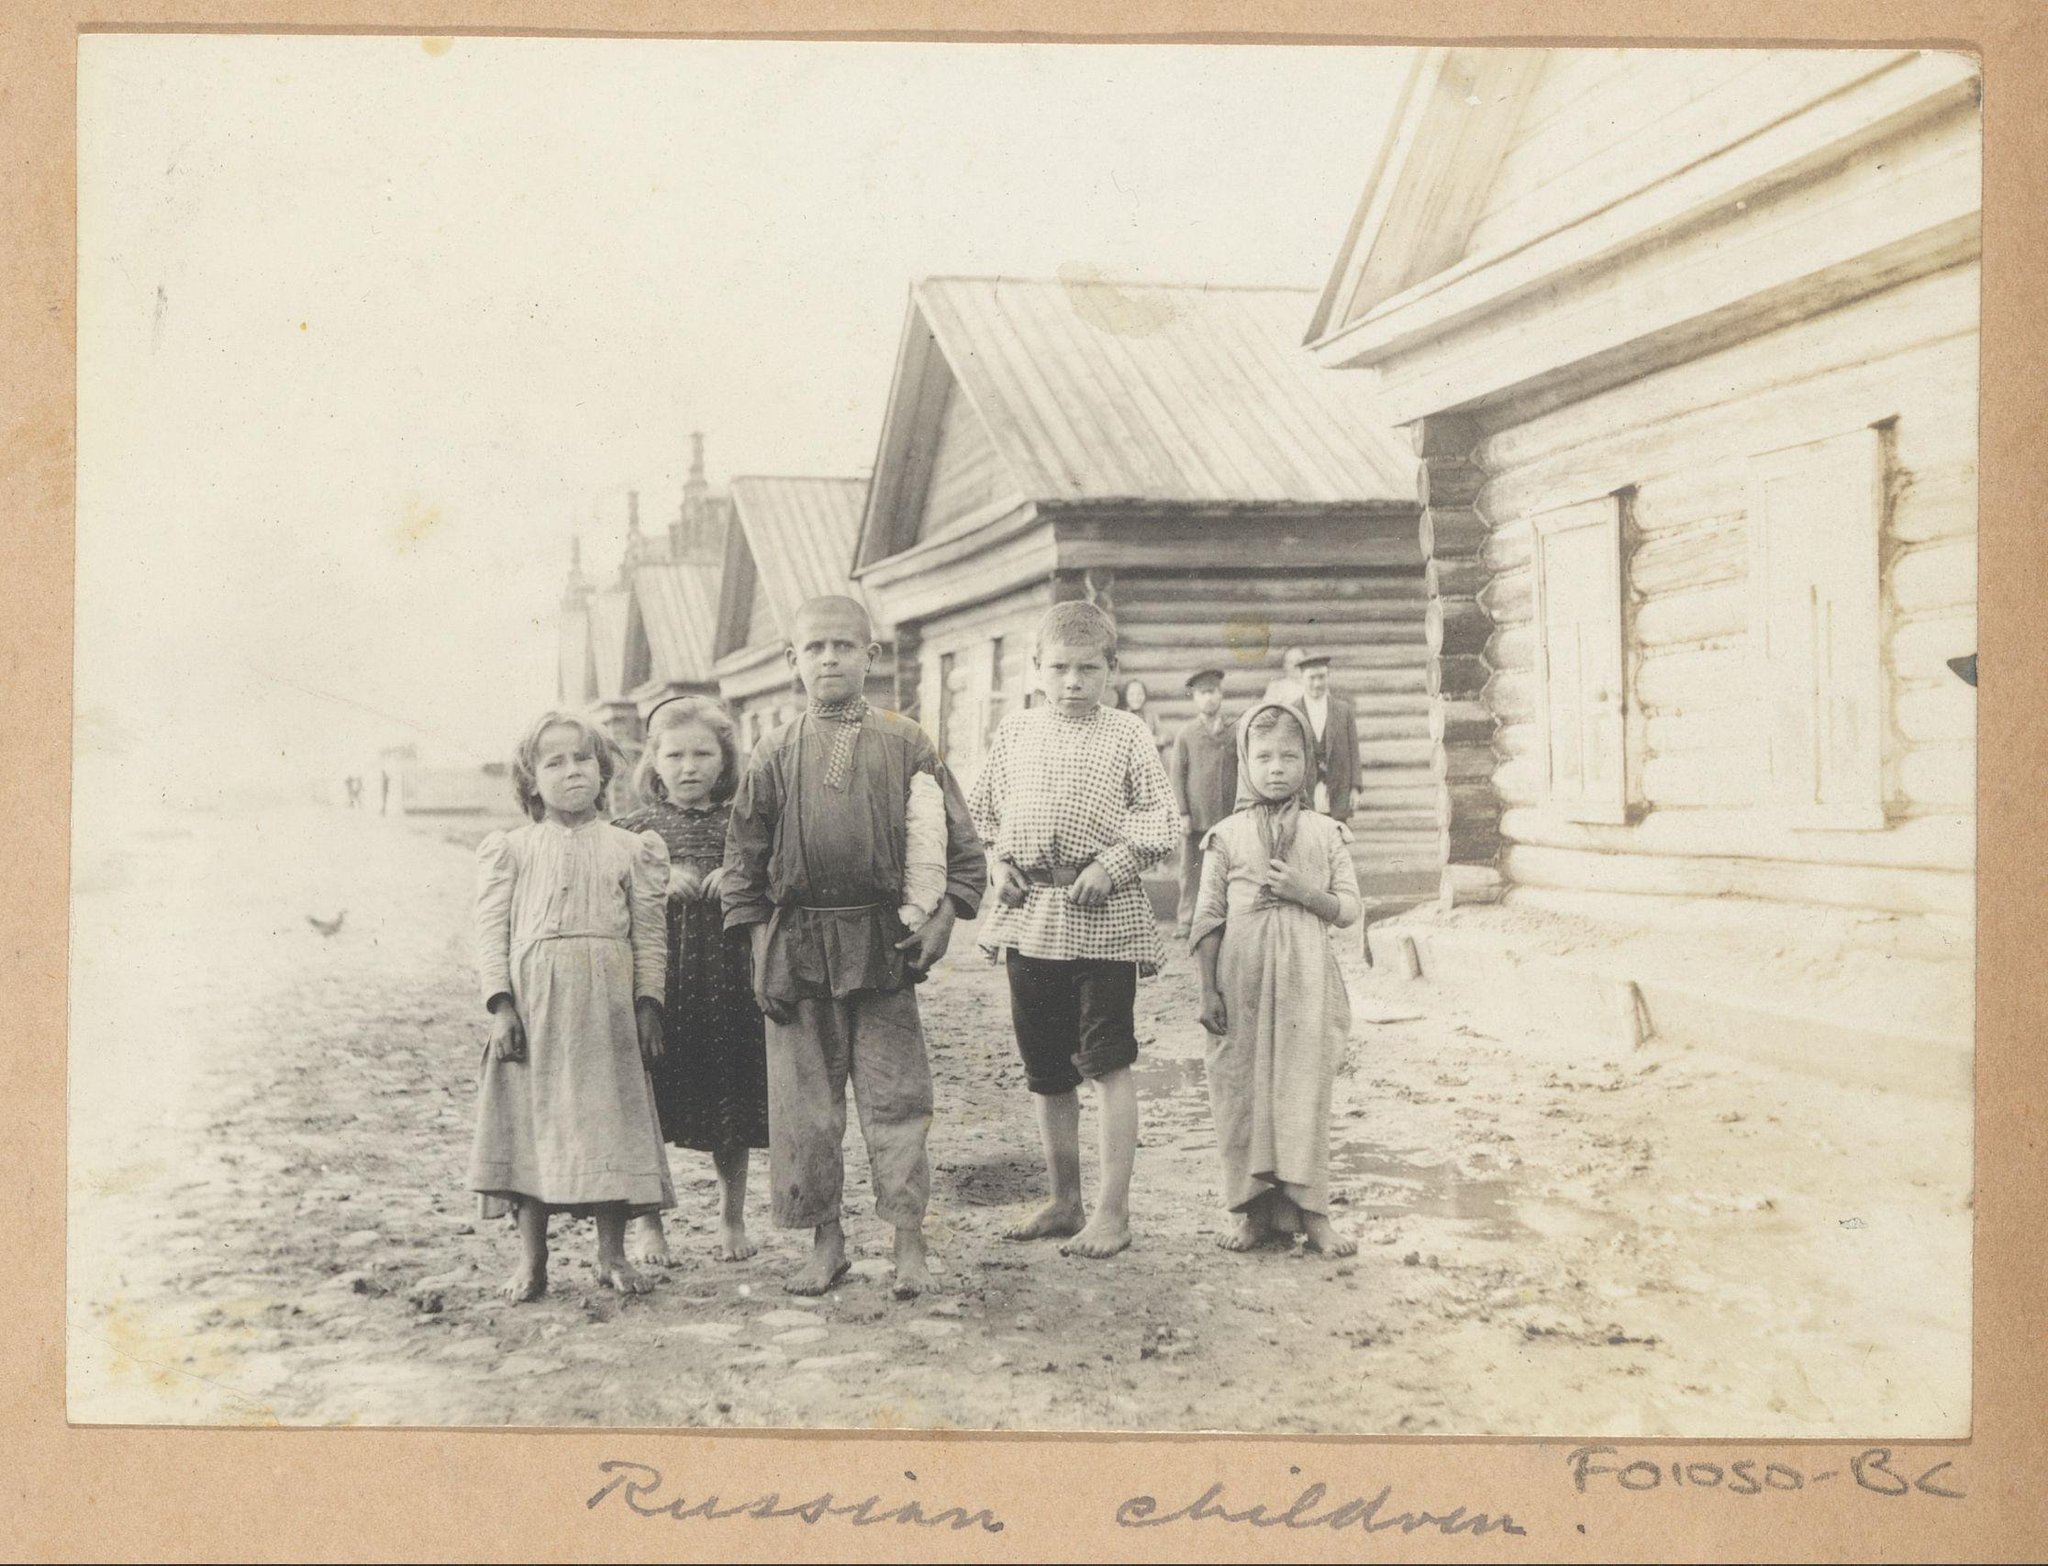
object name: photograph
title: Russische kinderen, blootvoets bij huizen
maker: joseph cheetham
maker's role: engineer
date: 1903-1904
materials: photographic support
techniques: gelatin silver print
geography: russia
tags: child, barefoot, russia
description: Onderdeel van Fotoalbum van de Engelse familie Cheetham met opnames van hun verblijf in Rusland.